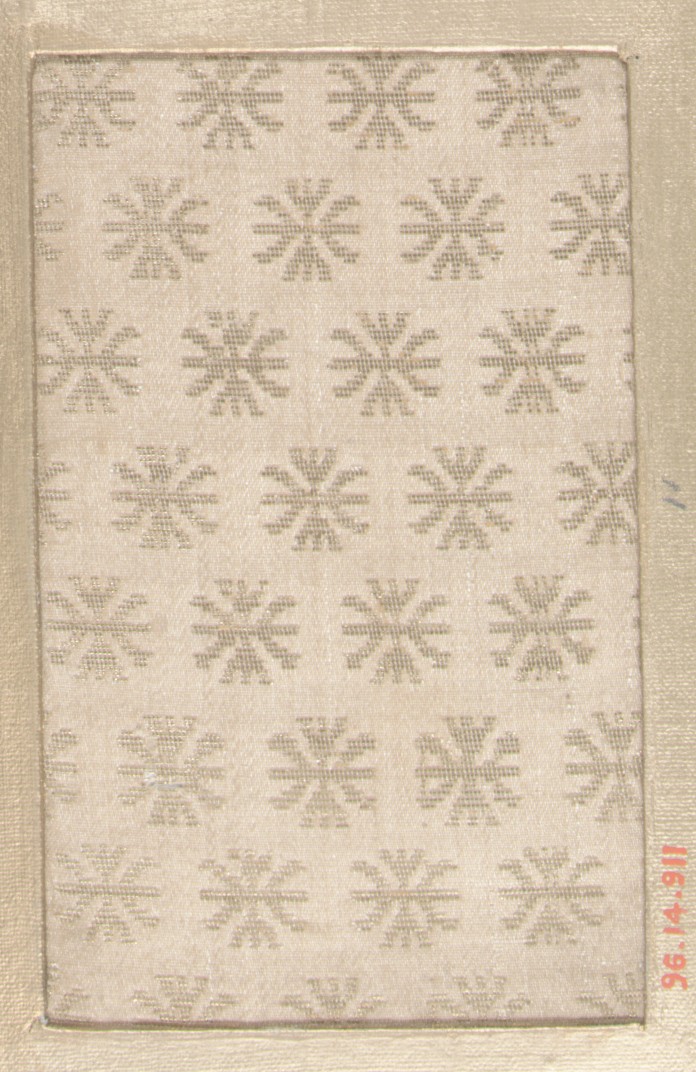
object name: piece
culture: japanese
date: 1701-1900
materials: silk